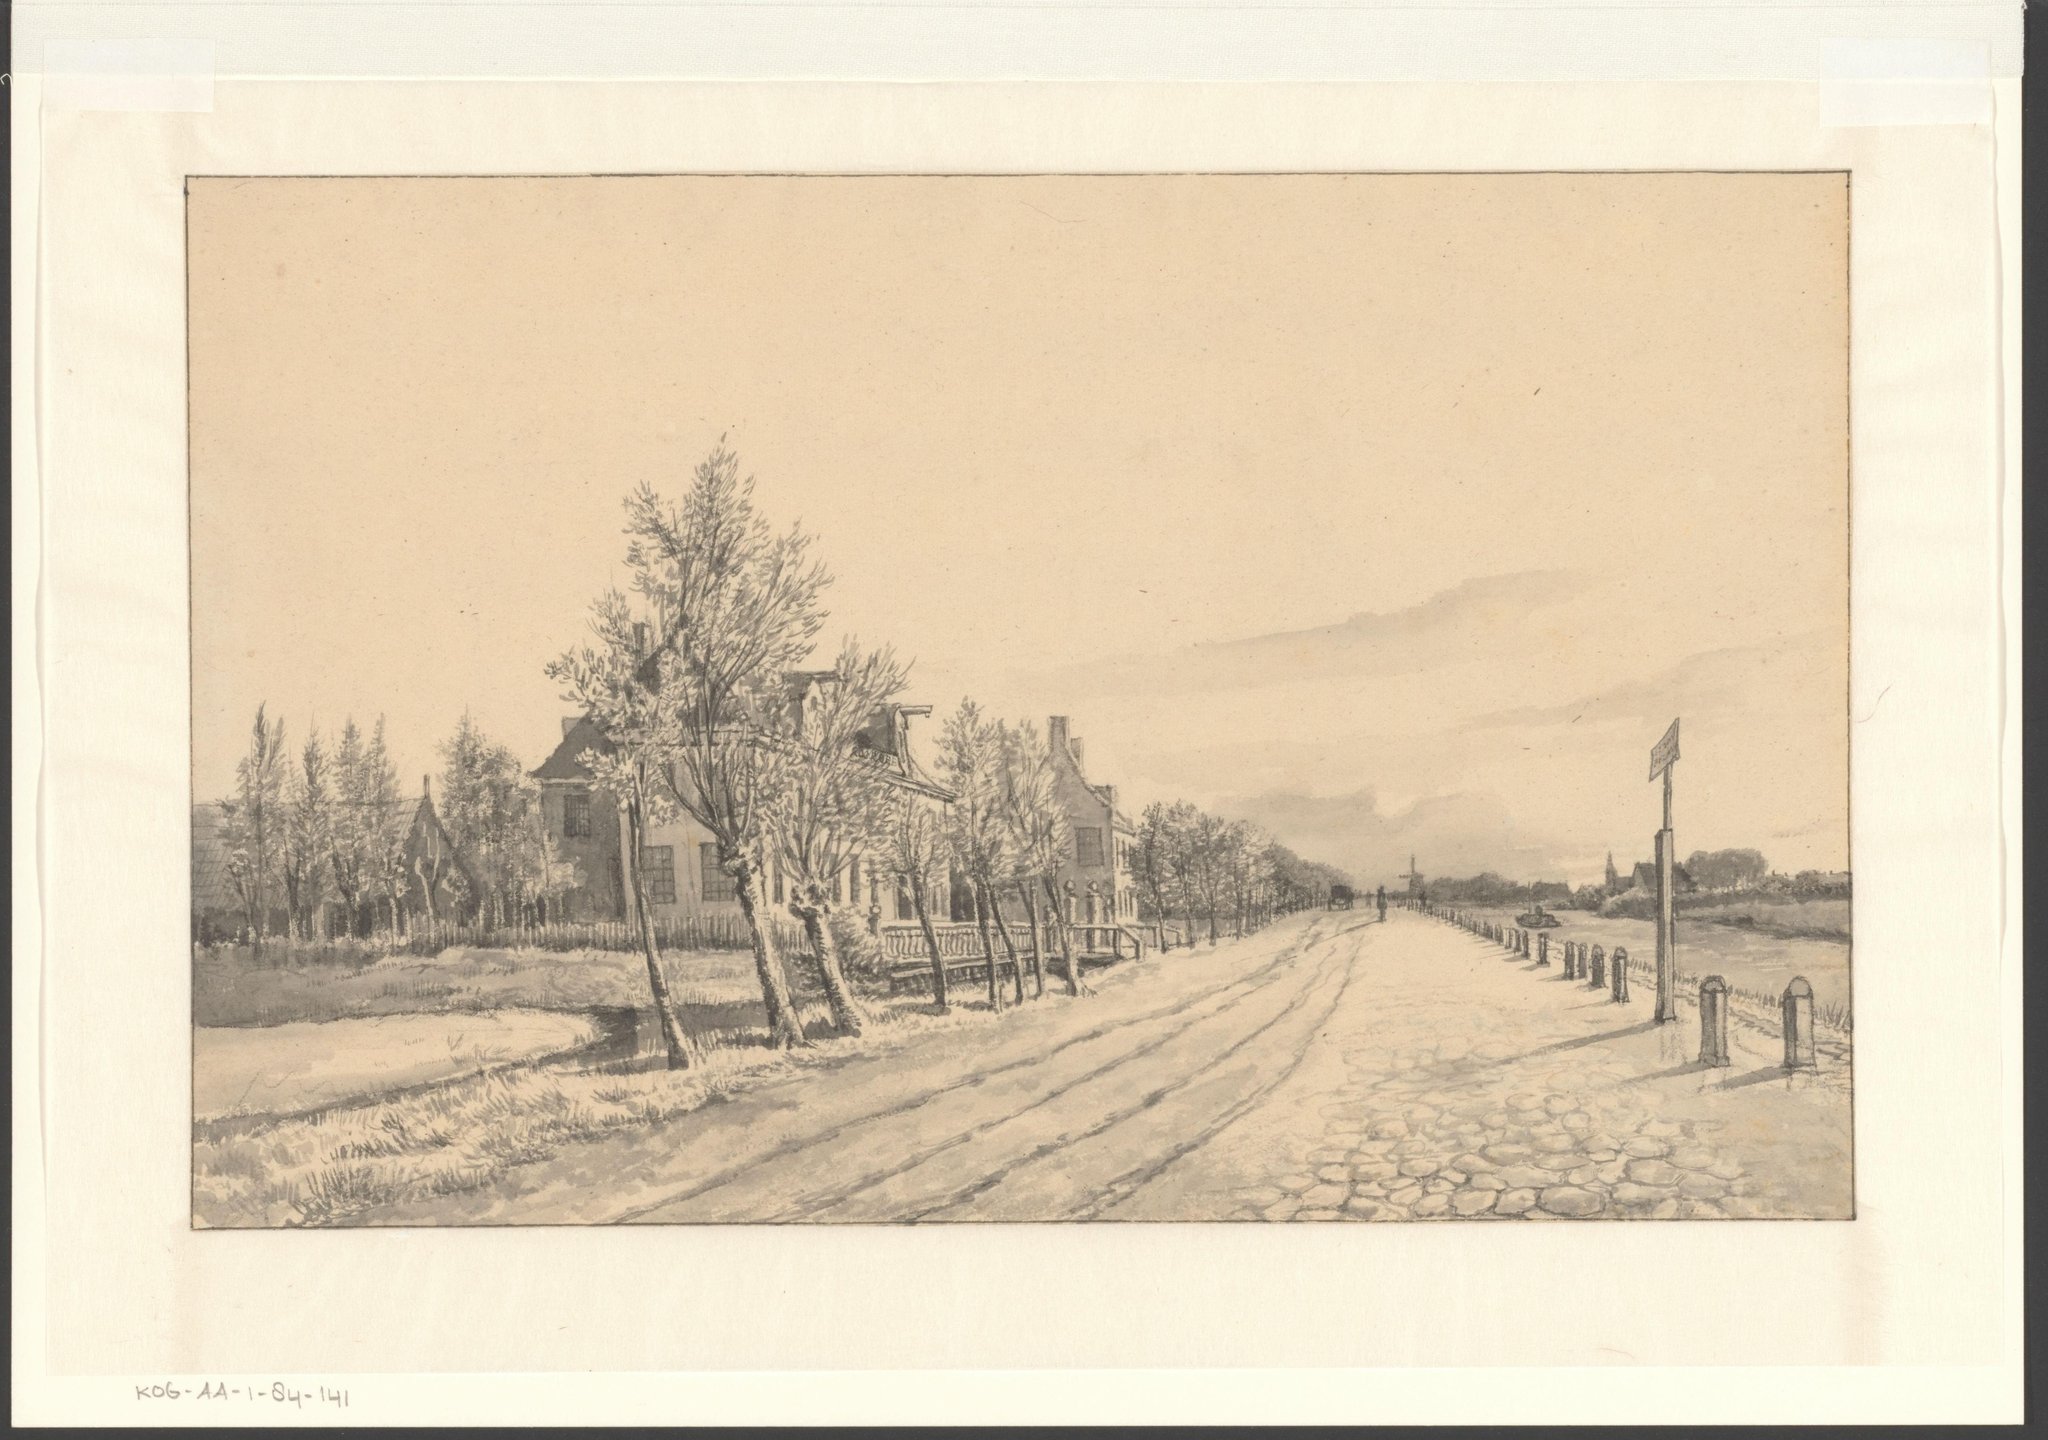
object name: drawing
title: Gezicht op herberg De 200 Roeden aan de Haarlemmerweg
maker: gerrit lamberts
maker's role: bookseller, draughtsman, print maker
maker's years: 1776-1850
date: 1816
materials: chalk, ink, paper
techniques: brush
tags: city-view in general; 'veduta', road, path, hotel, hostelry, inn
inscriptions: signature, date and inscription: ‘de Herberg aan (...) G Lamberts a. 1816.’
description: Onderwerpsrubriek binnen de Atlas Amsterdam: Haarlemmerweg.